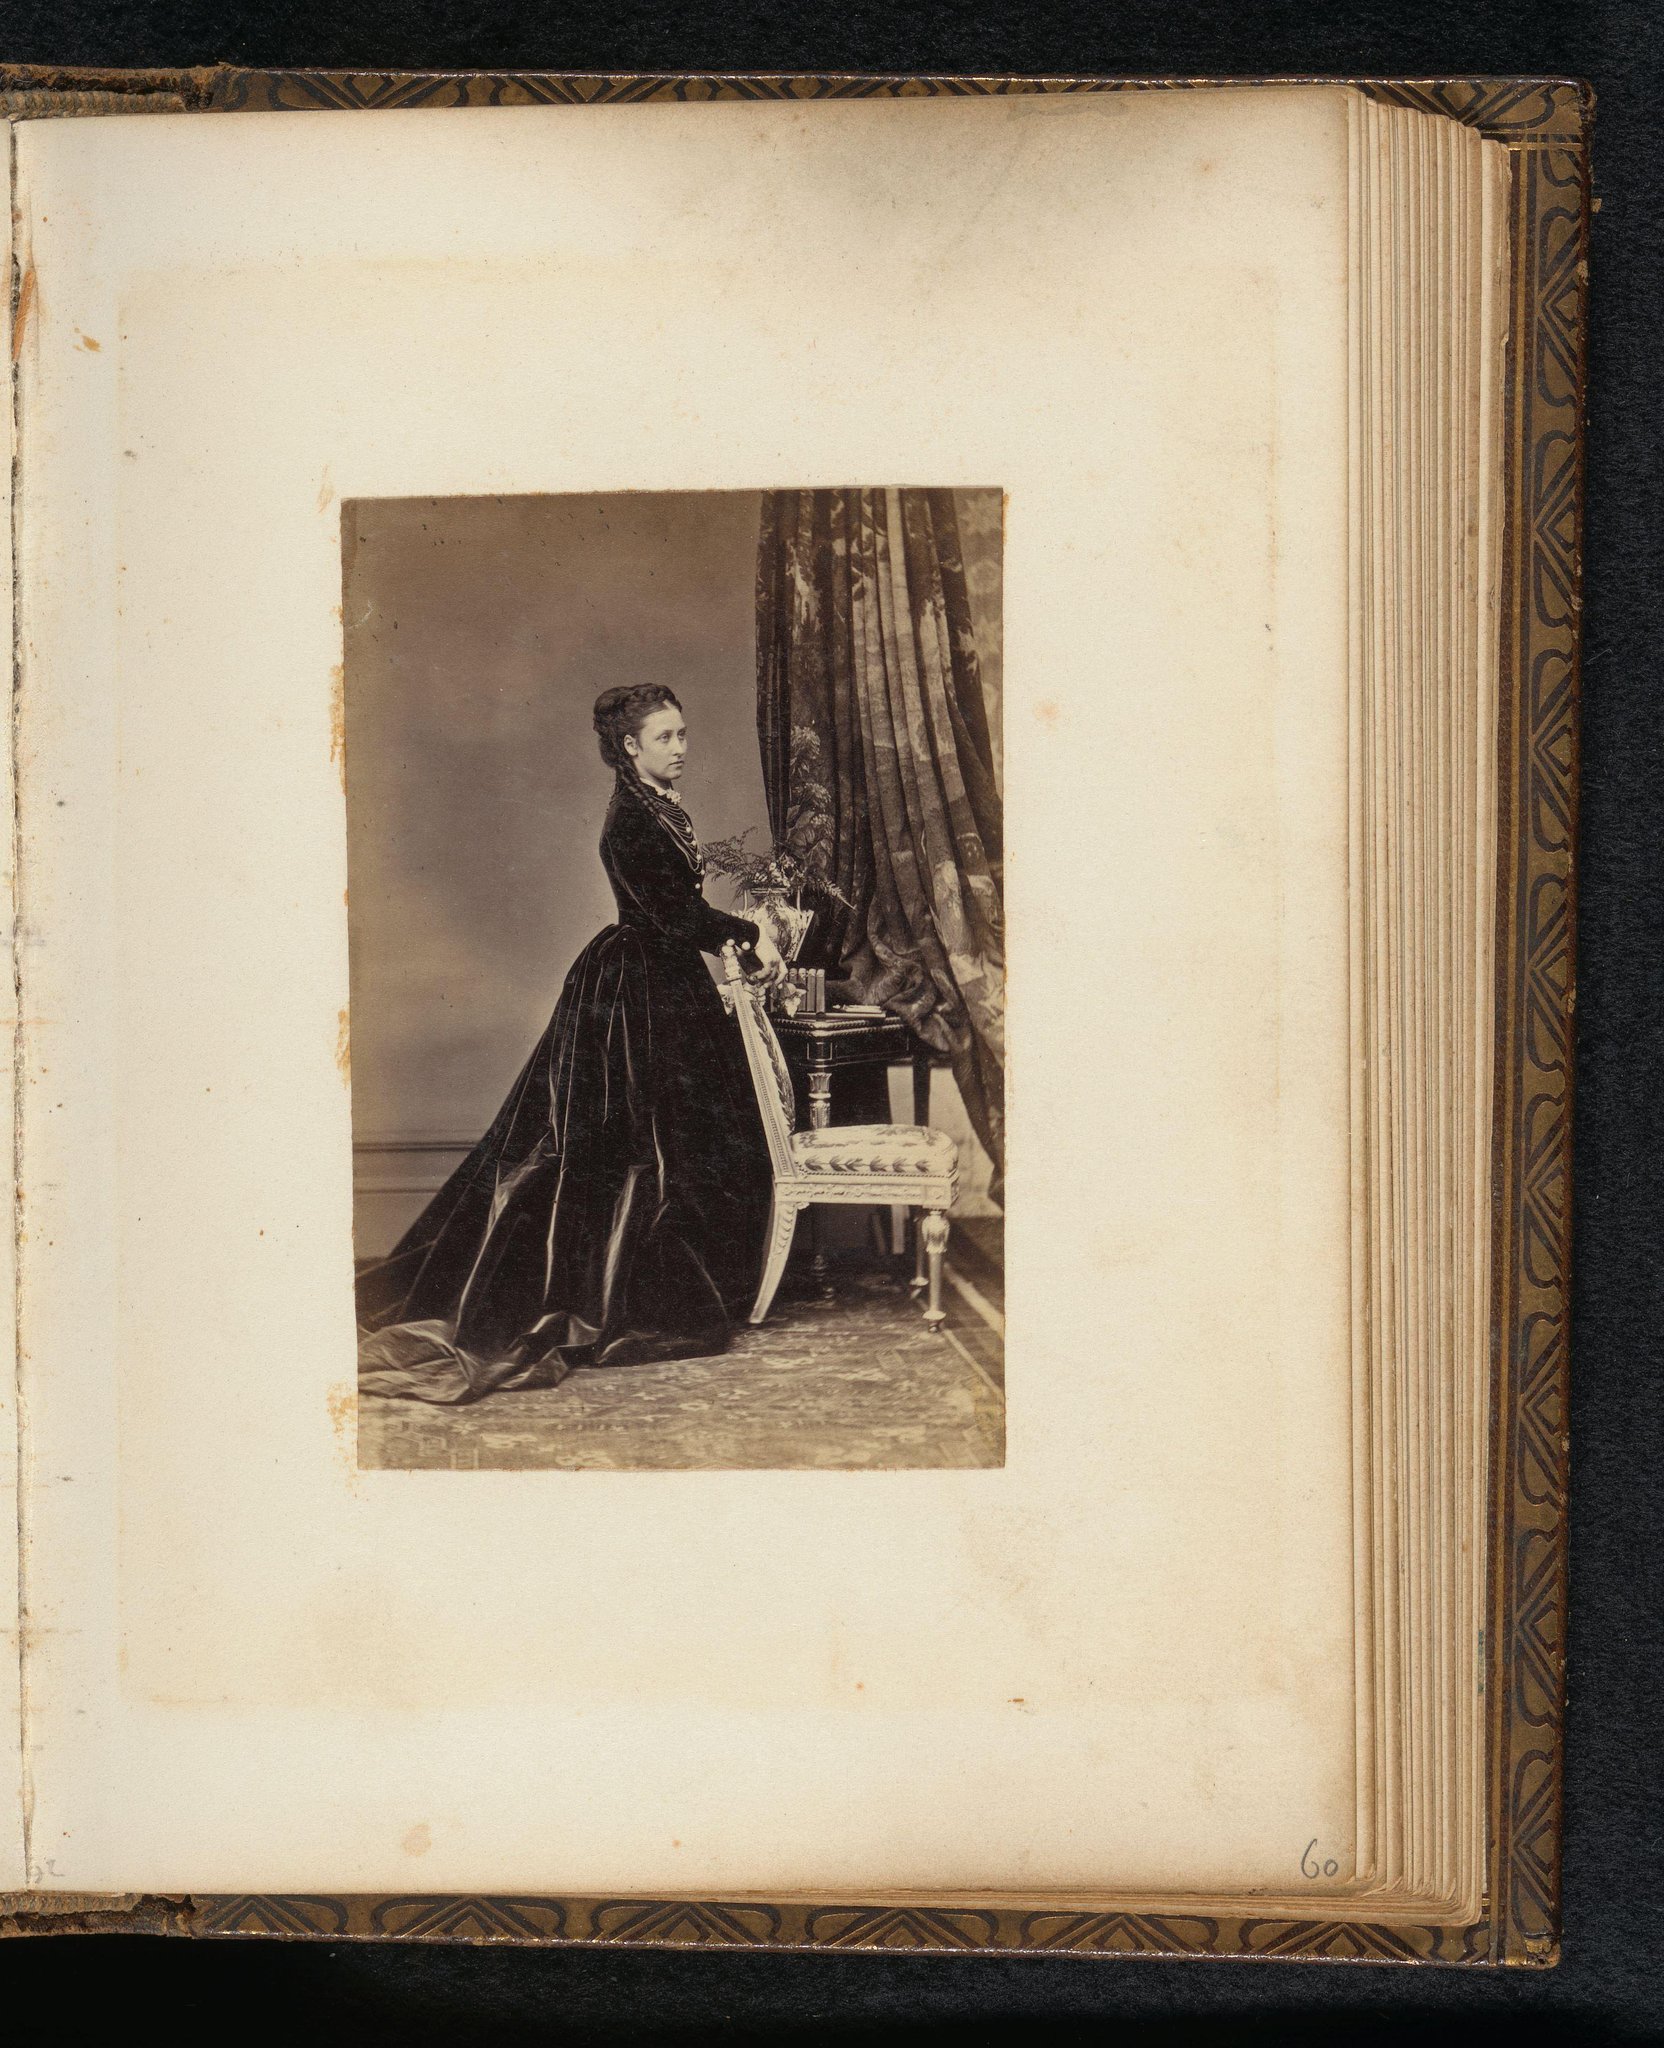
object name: photograph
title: Portret van een vrouw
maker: Anonymous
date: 1865-1867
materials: cardboard, photographic support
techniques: albumen print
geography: england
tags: anonymous historical person portrayed - bb - woman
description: Portret van een onbekende vrouw, staande naast een stoel en tafel. Foto op albumblad in album met 68 foto's merendeels met geaquarelleerde randversieringen. Het zijn voornamelijk portretten op carte-de-visite formaat.